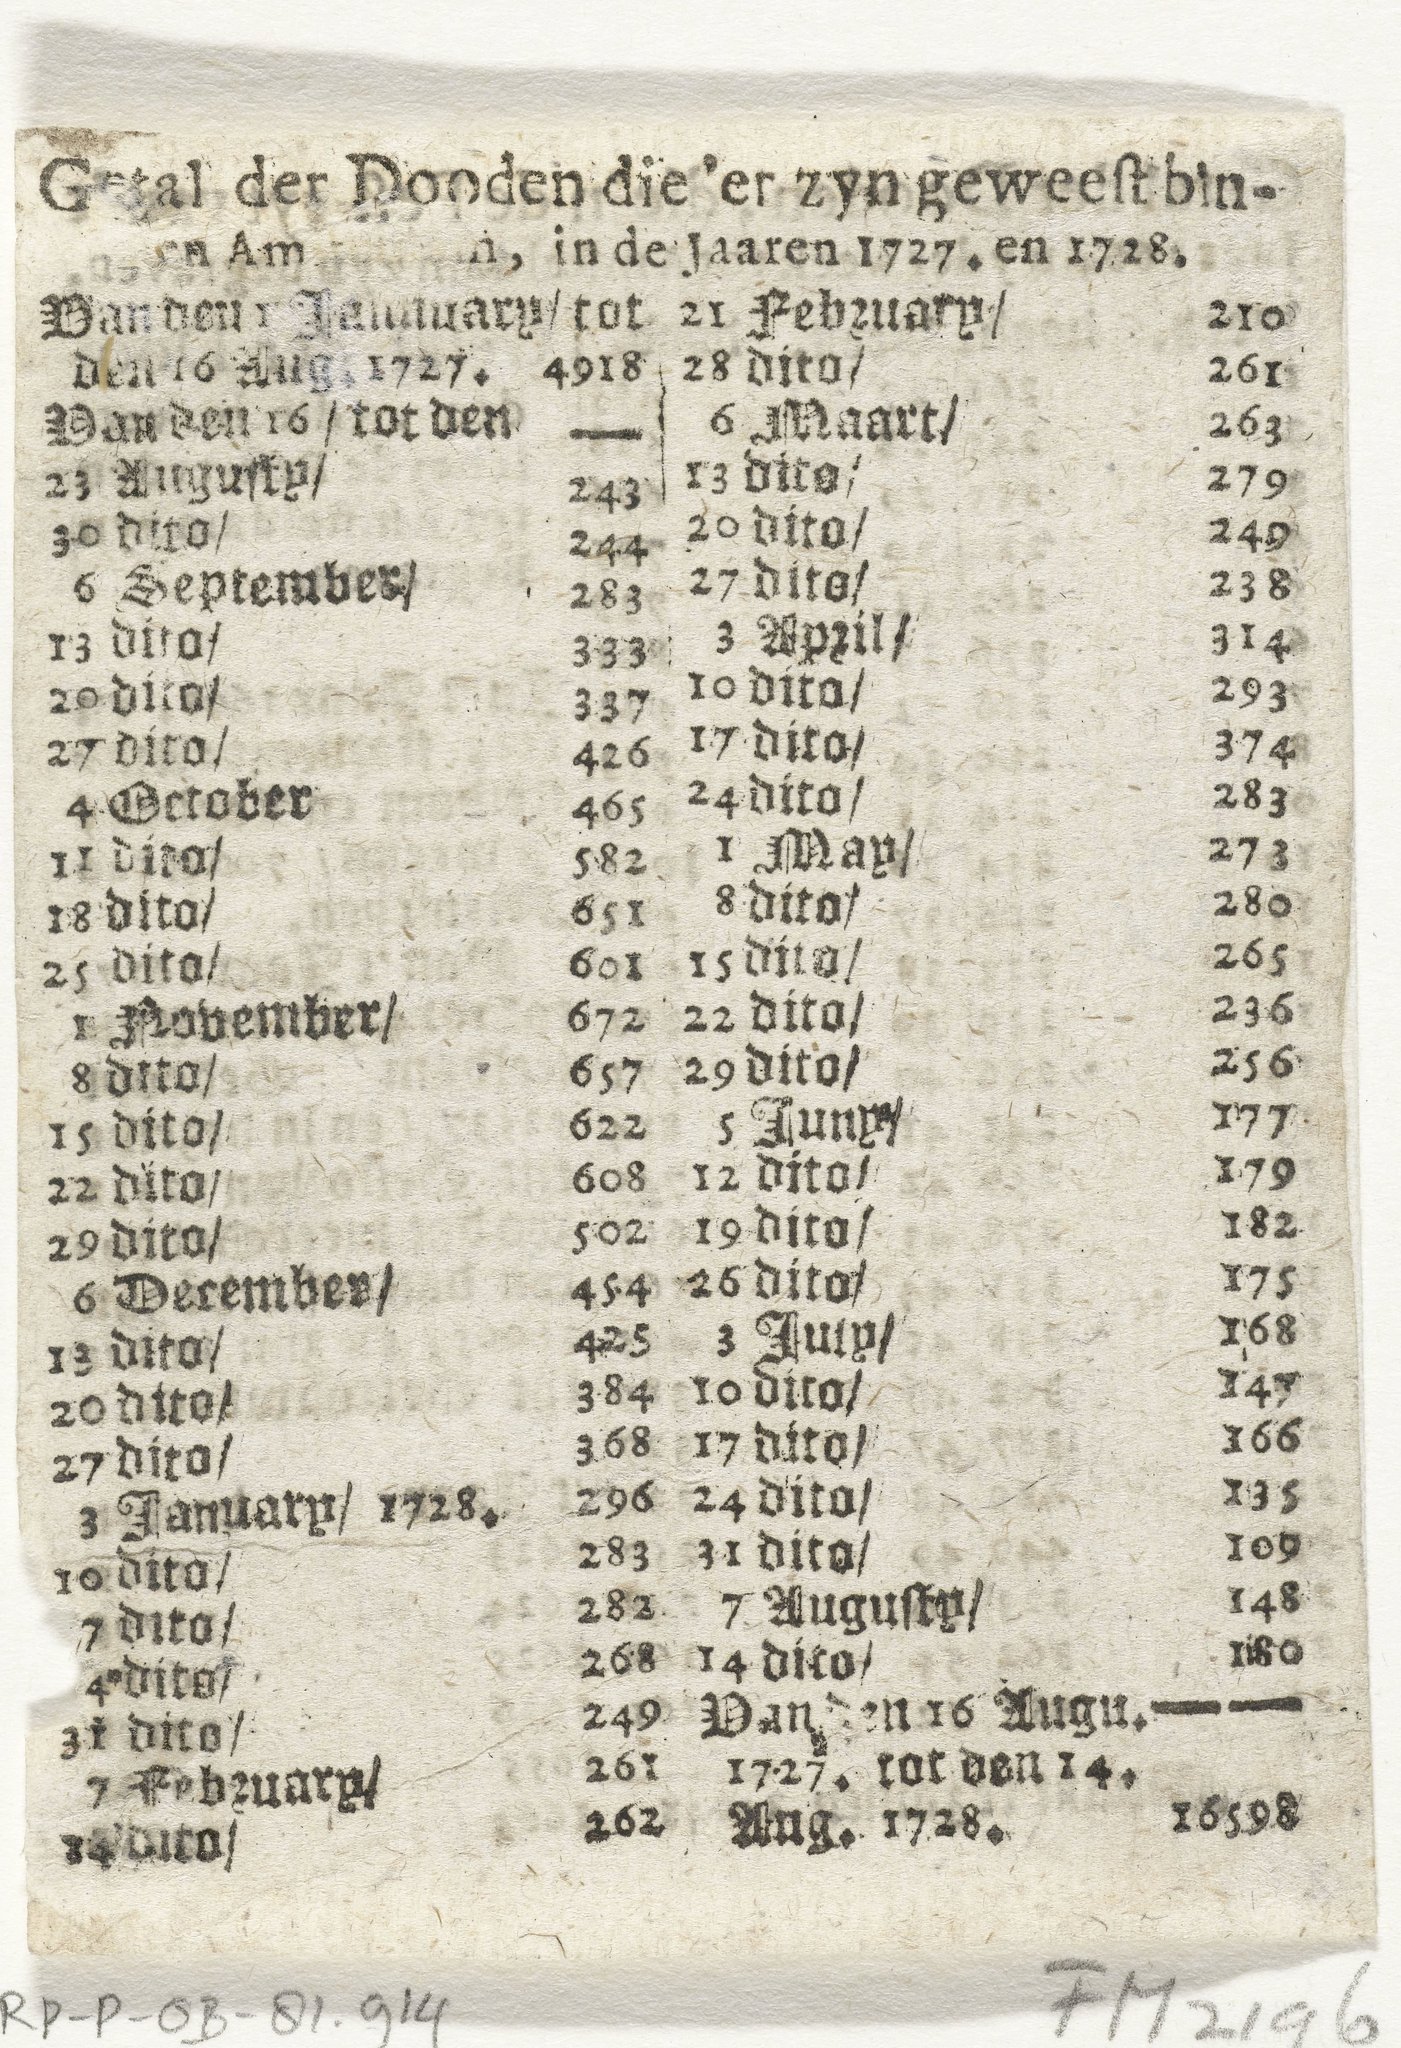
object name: text sheet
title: Getal der Dooden, die in de Pest-tyt van 't Jaar 1664 in yder week tot Amsteldam zyn begraven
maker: Anonymous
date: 1728-1749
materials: paper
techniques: letterpress printing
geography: northern netherlands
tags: amsterdam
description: Twee gedrukte lijstjes van de aantallen doden gevallen in Amsterdam. Voorzijde: het aantal doden in de jaren 1727-1728: 16598. Achterzijde: het aantal doden gestorven aan de pest in het jaar 1664: 24148.